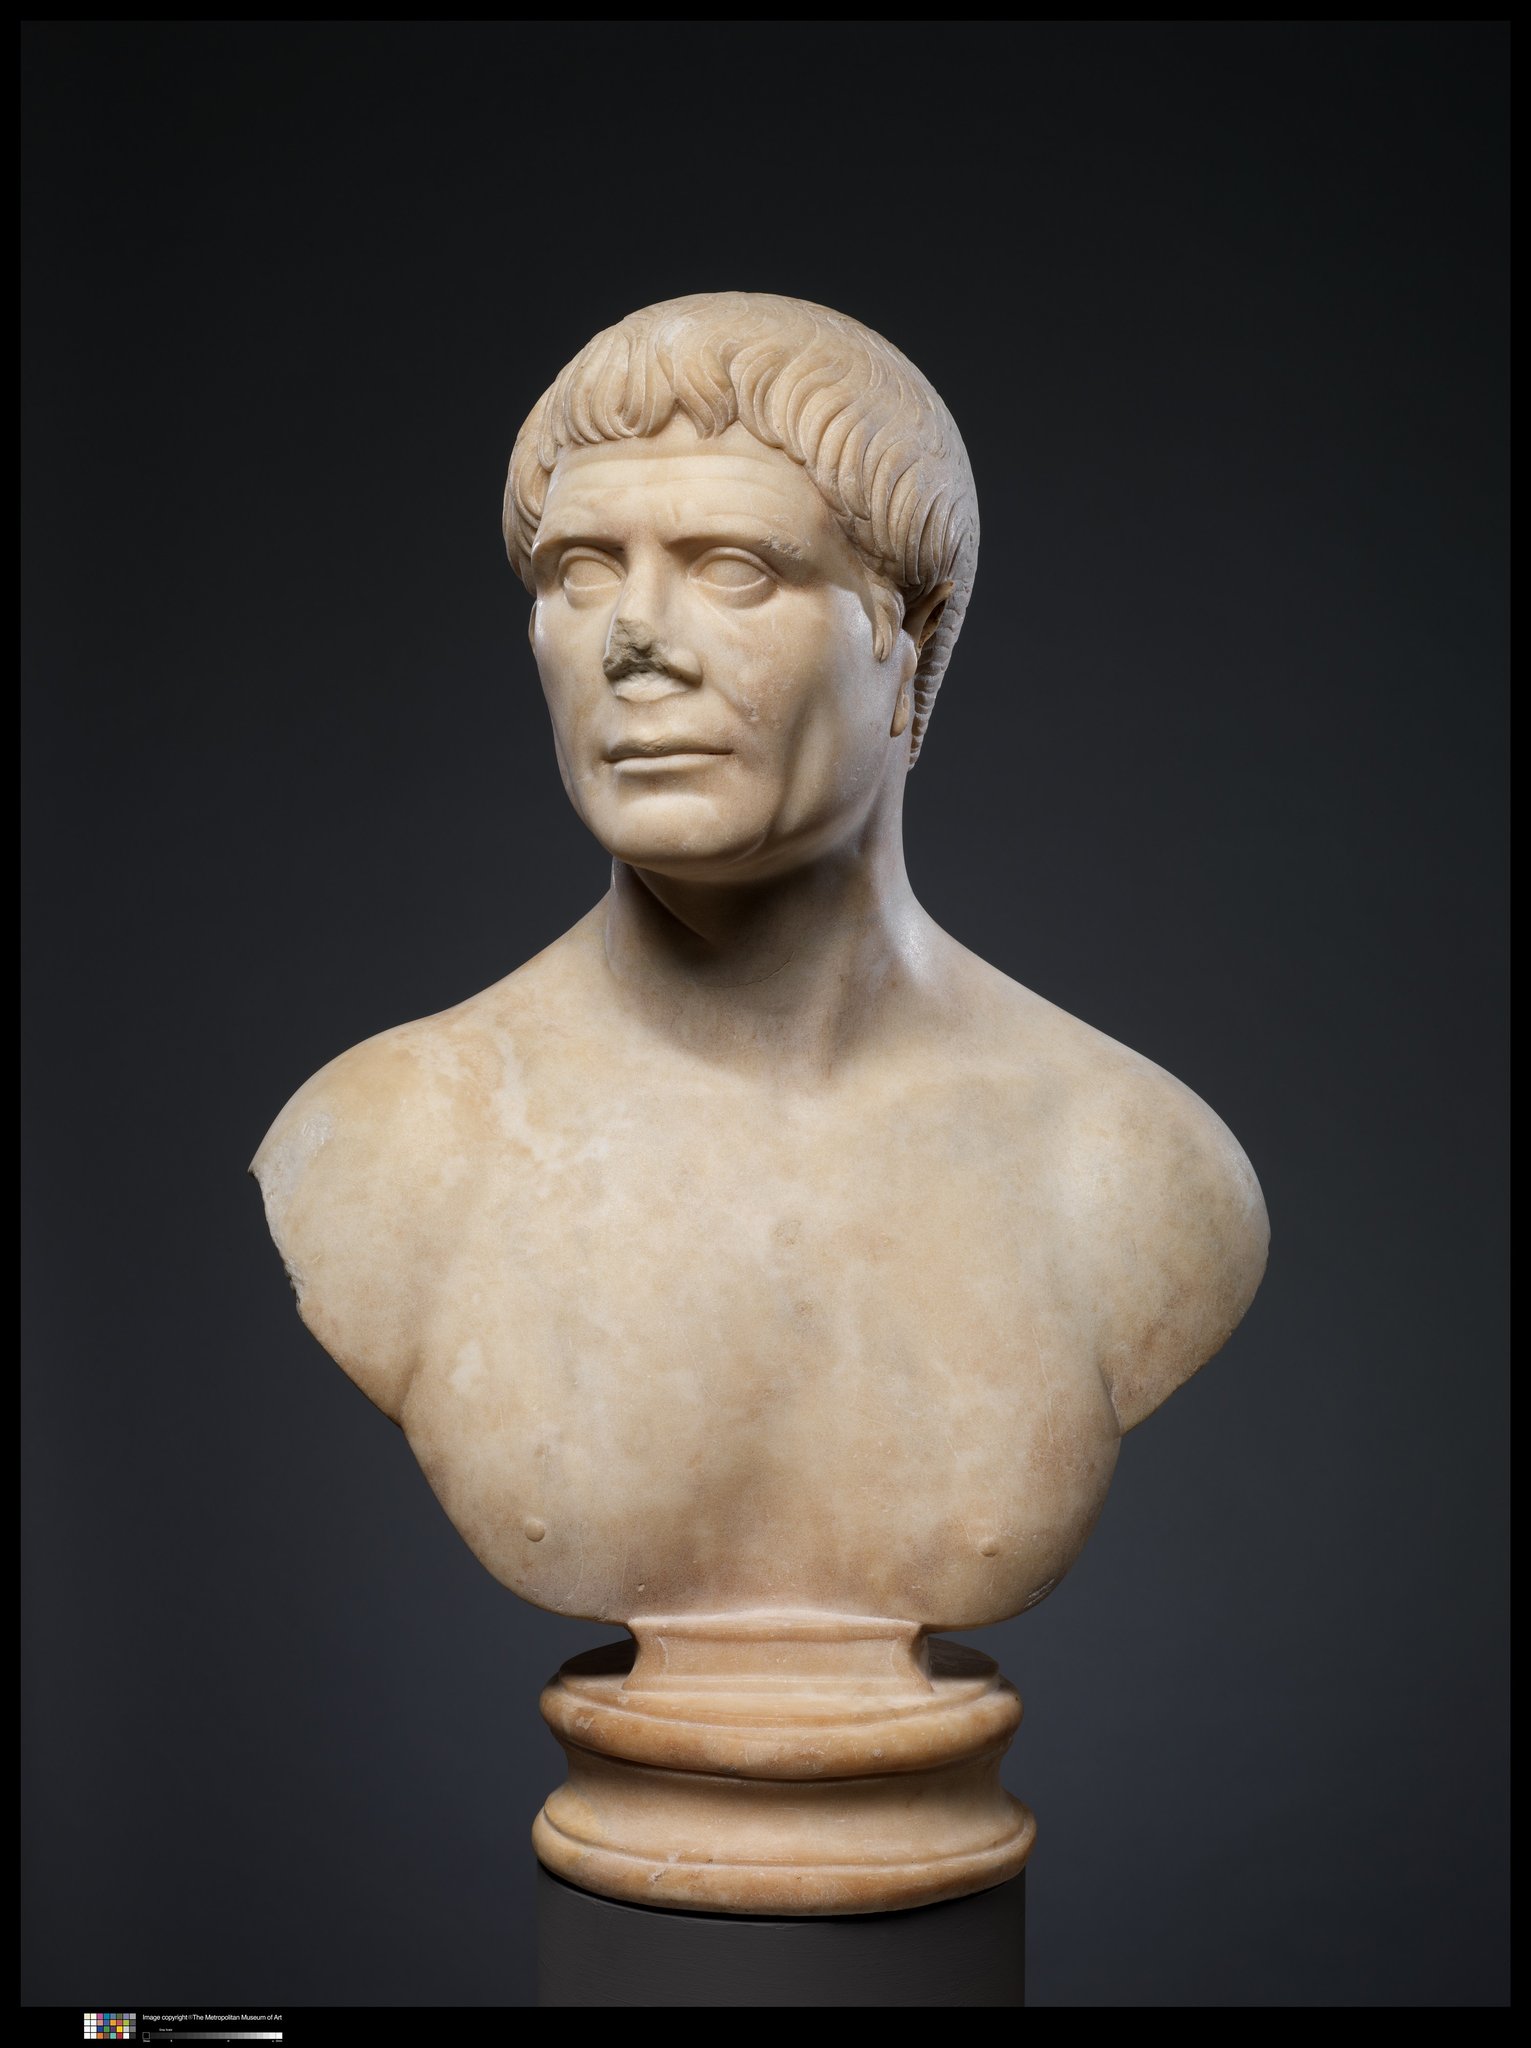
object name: portrait bust of a man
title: Marble portrait bust of a man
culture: roman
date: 110-120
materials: marble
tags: men,portraits